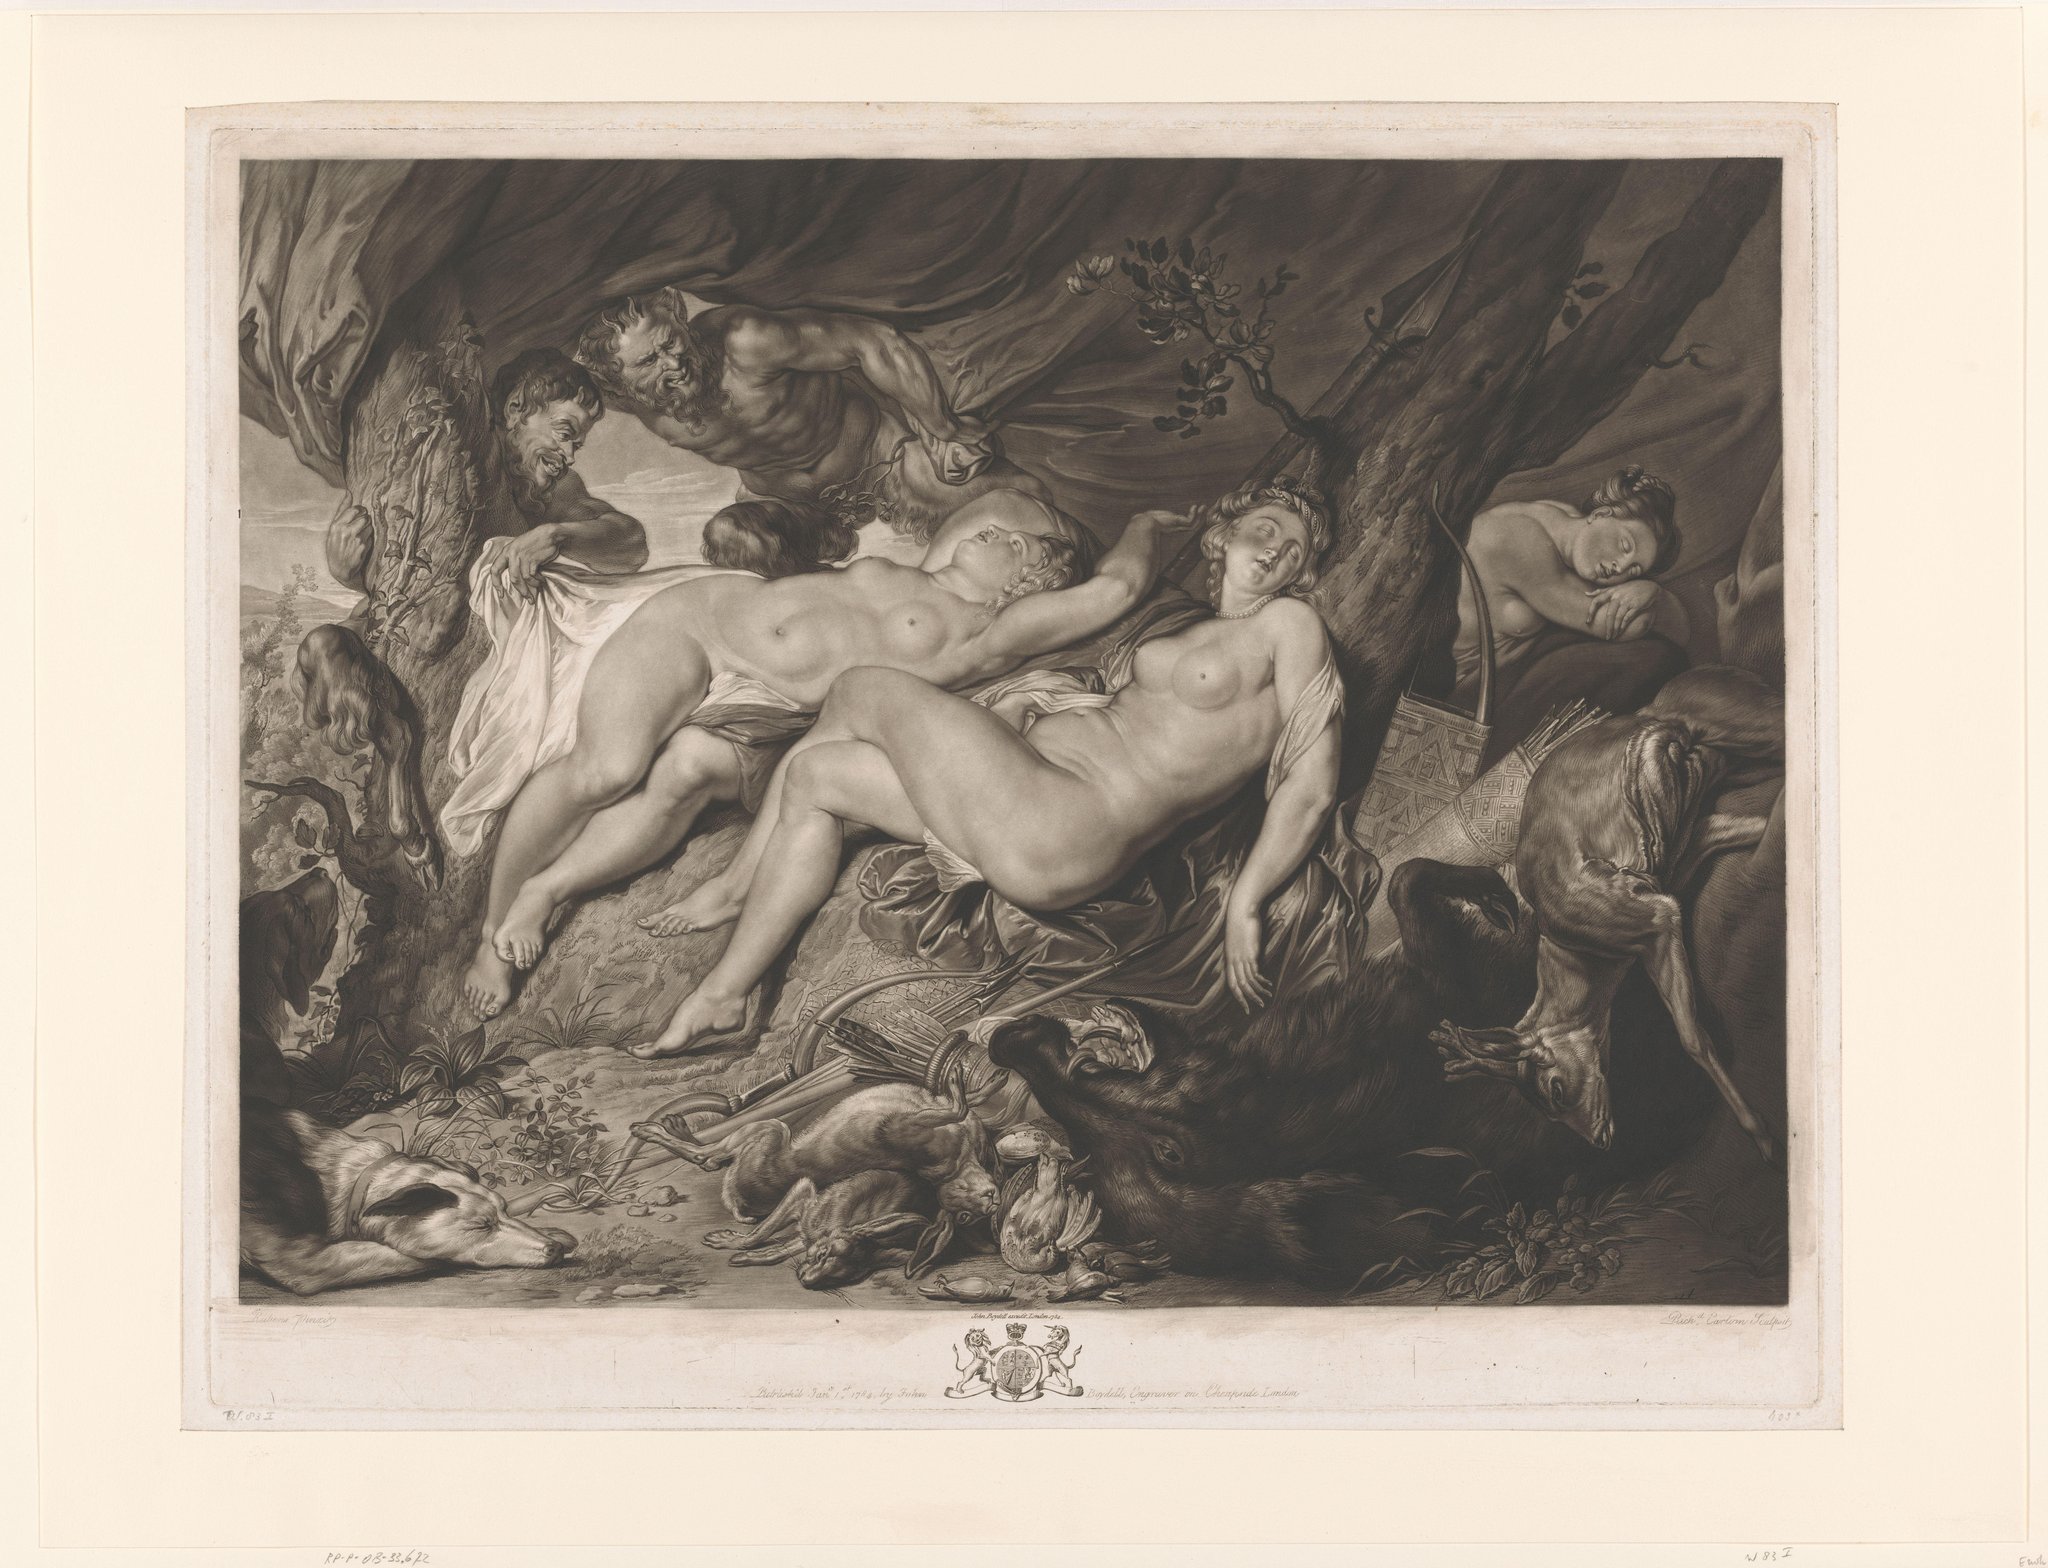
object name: print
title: Slapende Diana en haar nimfen bespied door saters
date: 1701-1784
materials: paper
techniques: etching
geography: london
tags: diana and her nymphs surprised by satyrs, sleeping; unconsciousness - bb - out of doors, game, hunted animals, satyr(s) spying upon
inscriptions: collector's mark: Lugt 240, inscription: ‘Nymphs and Satyrs, In his Majestys Collection at the Royal apartements Windsor Castele[s?]’